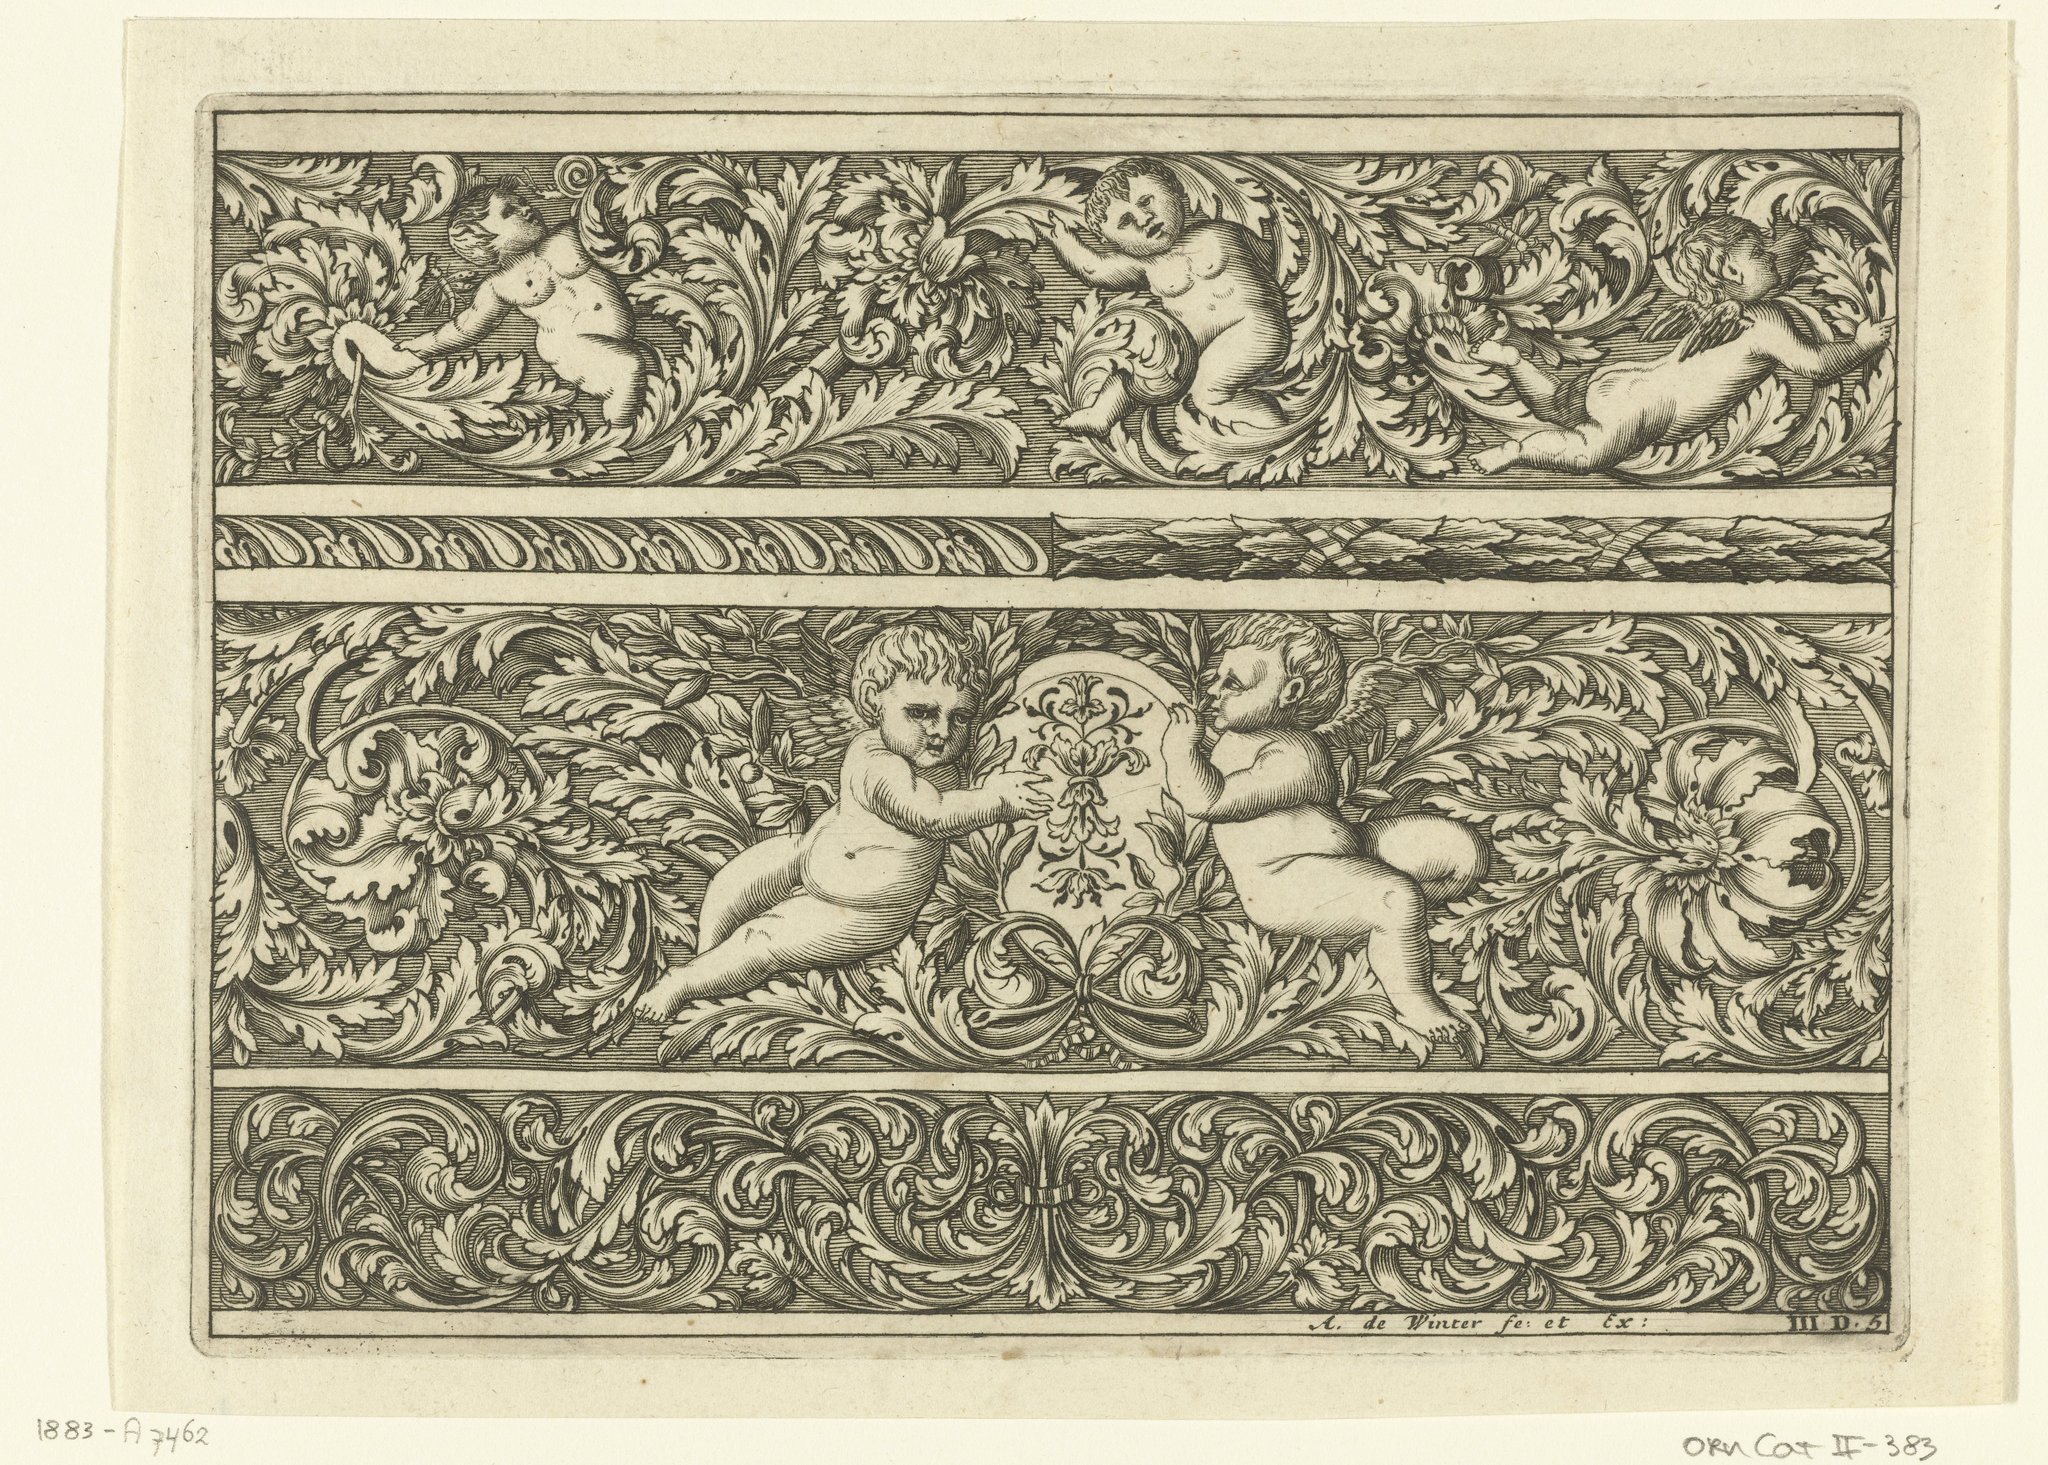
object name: ornament print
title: Drie friezen met bladranken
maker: anthonie de winter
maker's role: print maker, publisher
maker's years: 1652-1707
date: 1696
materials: paper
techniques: engraving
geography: amsterdam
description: In de bovenste twee friezen, gescheiden door een eierlijst, zijn putti afgebeeld. Blad III.D.5 uit derde serie van 12 bladen met ornamenten voor goud- en zilversmeden. Kopieën naar C. de Moelder en anderen.